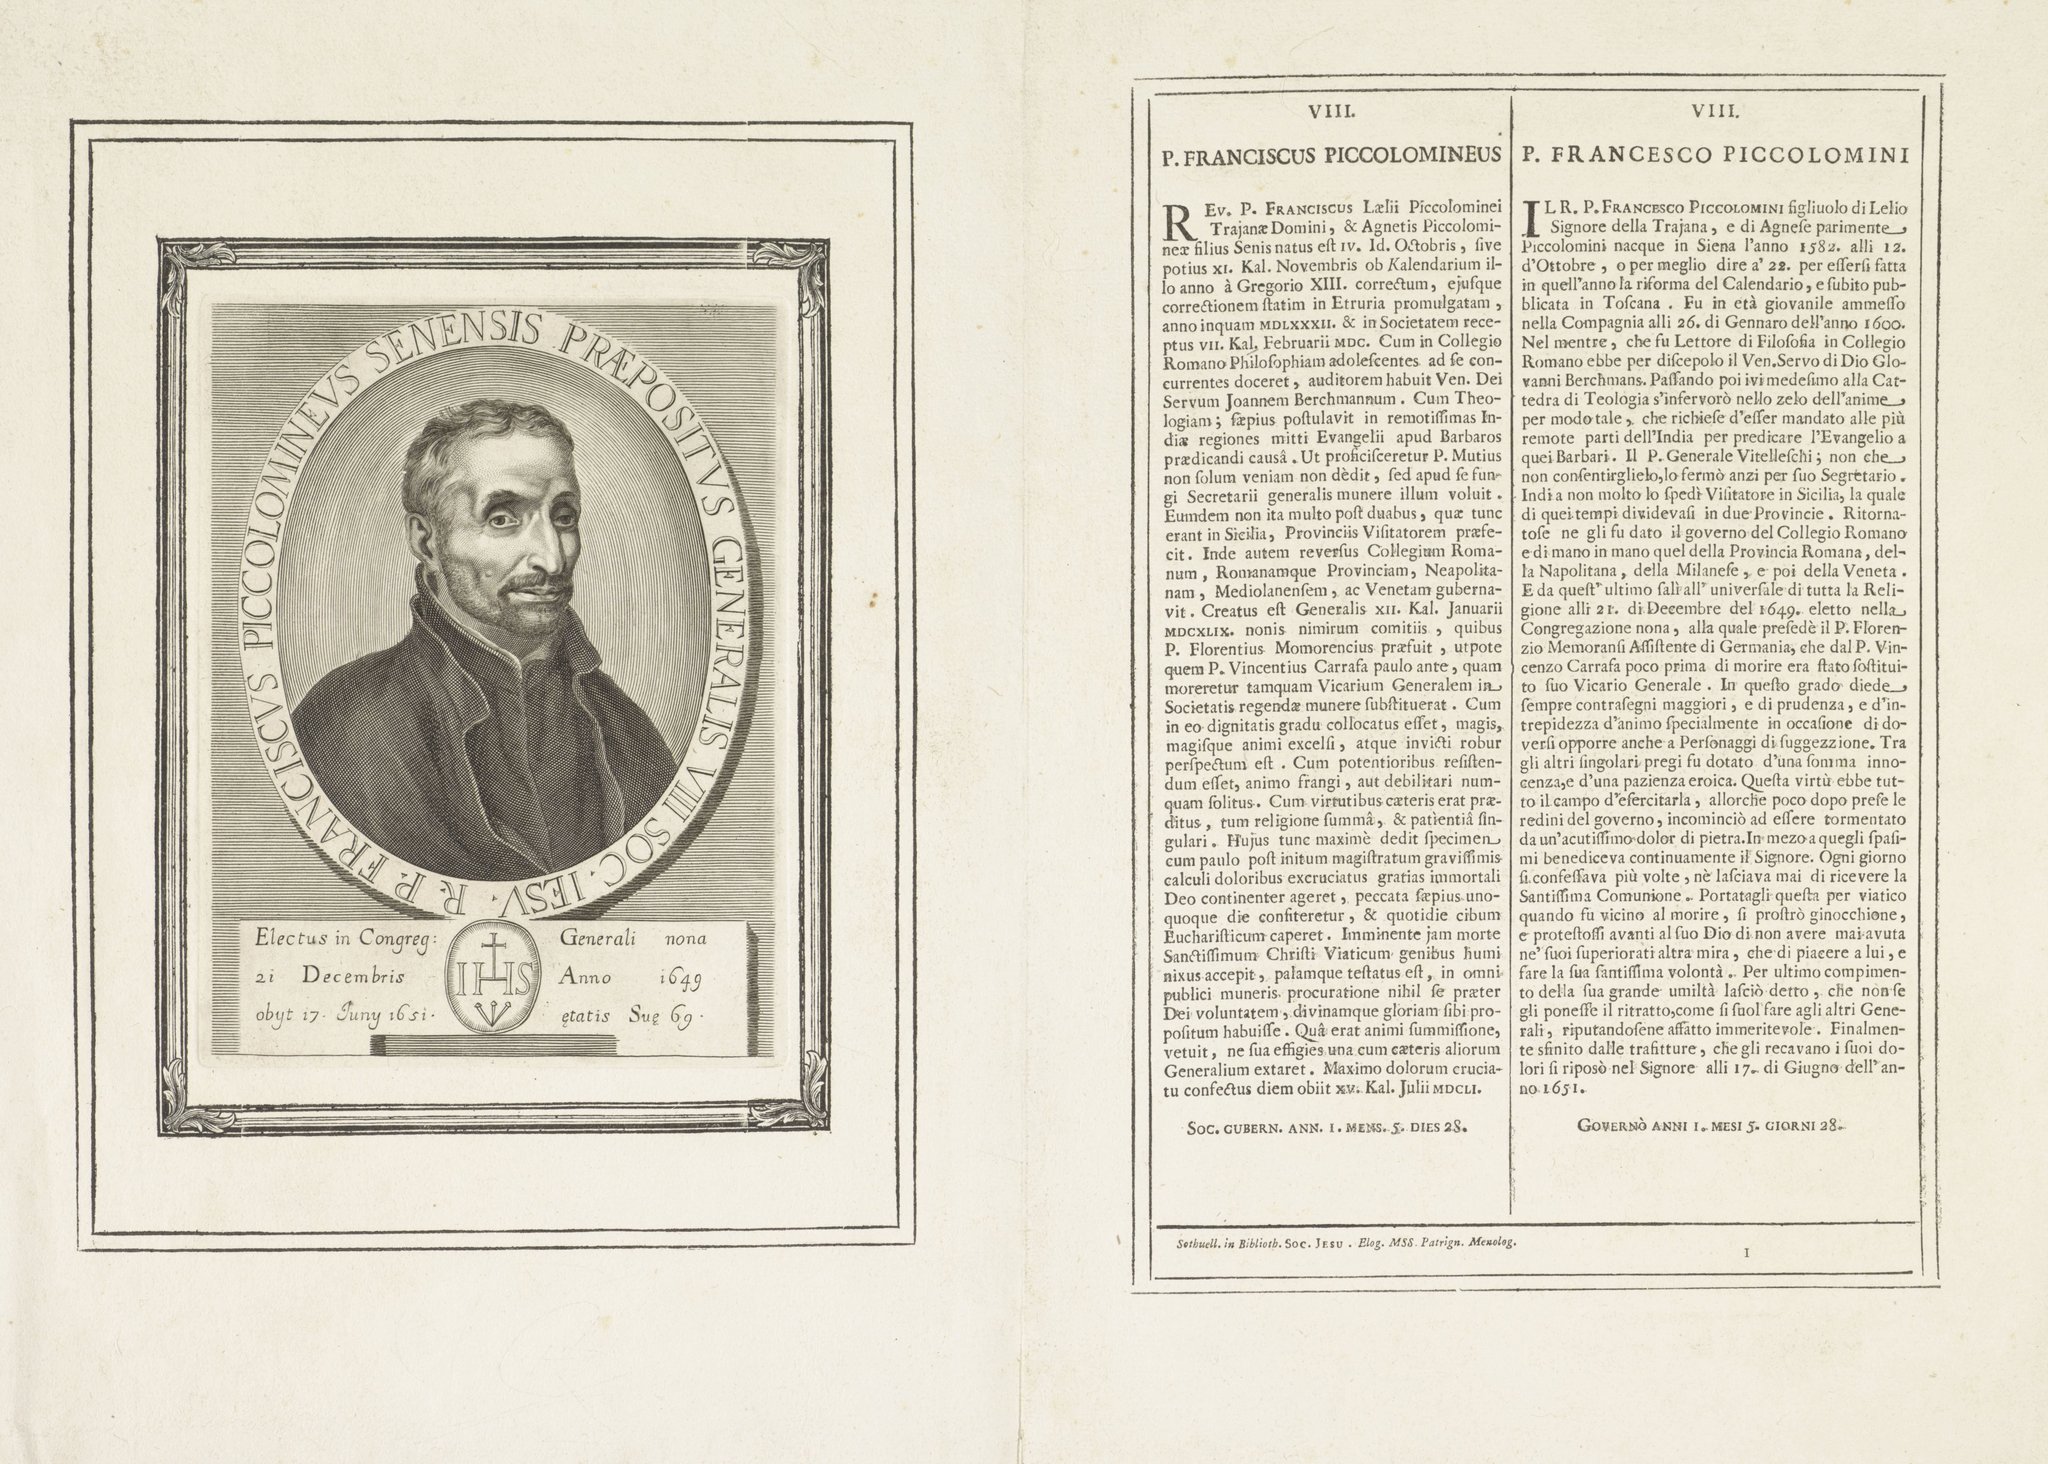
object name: book illustration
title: Portret van de Italiaanse priester Francesco Piccolomini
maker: arnold van westerhout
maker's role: print maker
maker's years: 1651-1725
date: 1751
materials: paper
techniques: engraving, etching, letterpress printing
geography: italy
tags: priest, ihs ('iesus hominum salvator') ~ symbol of christ, historical persons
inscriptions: title: ‘R.P. FRANCISCUS PICCOLOMINEUS SENENSIS PRAEPOSITUS GENERALIS VIII. SOC. IESU’, collector's mark: Lugt 2228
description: Prent gebruikt in: Galeotti, Niccolò. Imagines praepositorum generalium Societatis Jesu, delineatae, et aereis formis expressae ab Arnoldo Van Westherhout, addita perbrevi uniuscujusque vitae descriptione. Rome: Monaldini, 1751.